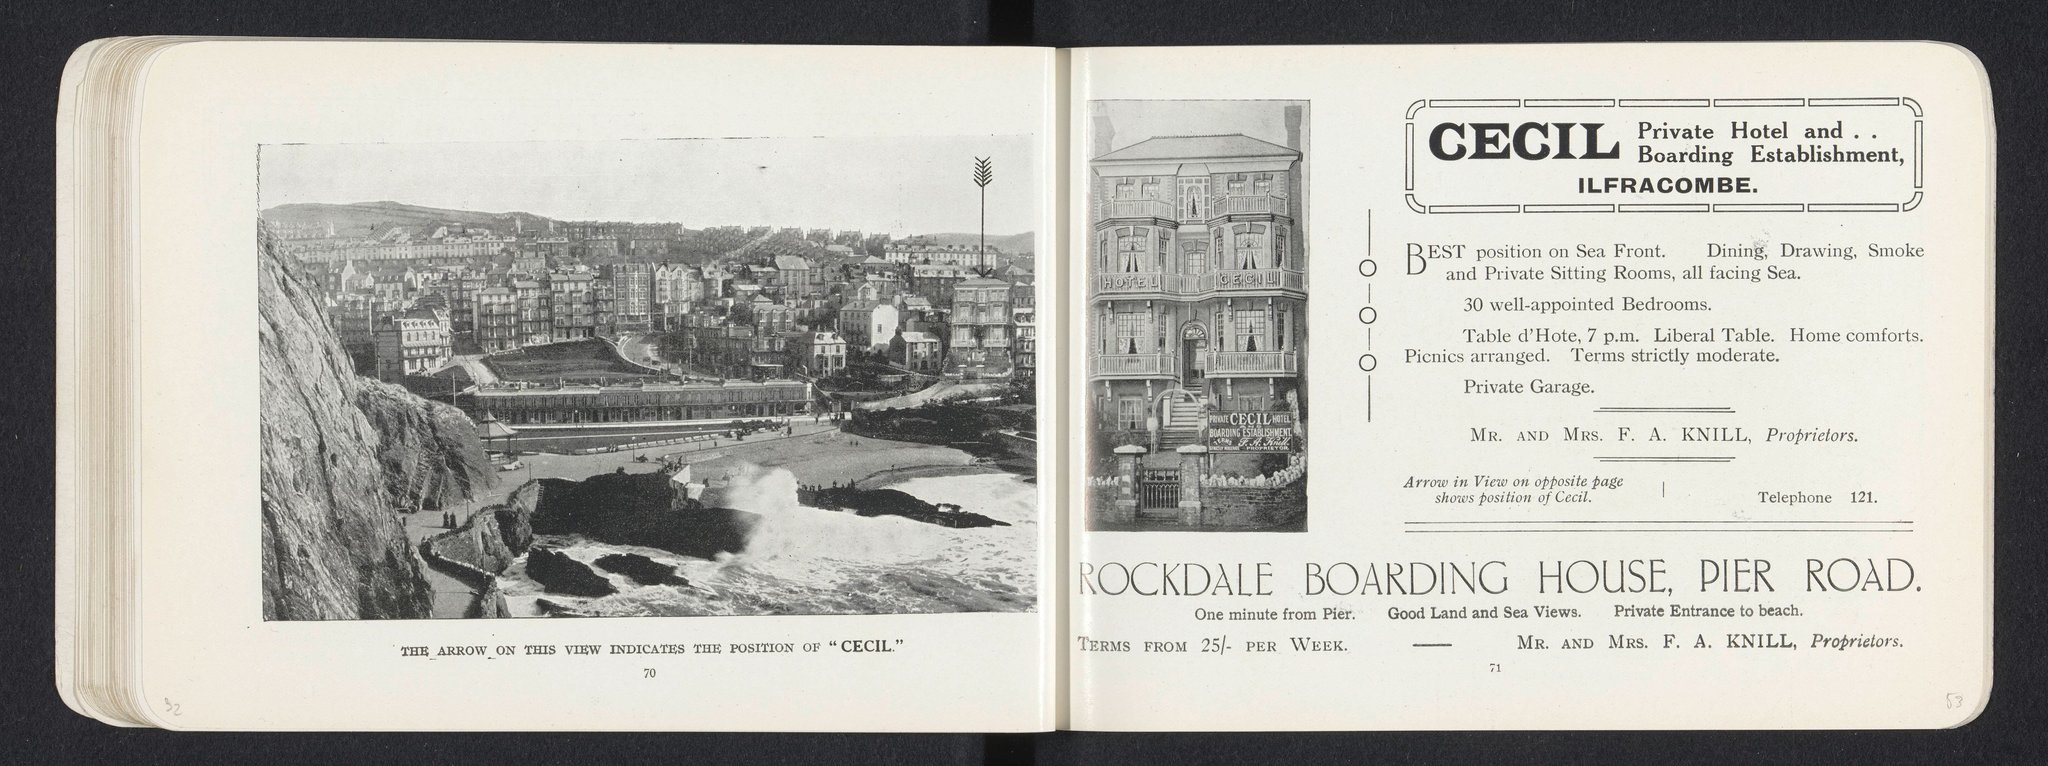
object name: page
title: Gezicht op Ilfracombe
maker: Anonymous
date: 1900-1920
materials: paper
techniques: autotype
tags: city-view in general; 'veduta'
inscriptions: inscription: ‘The arrow on this view indicates the position of "Cecil".’